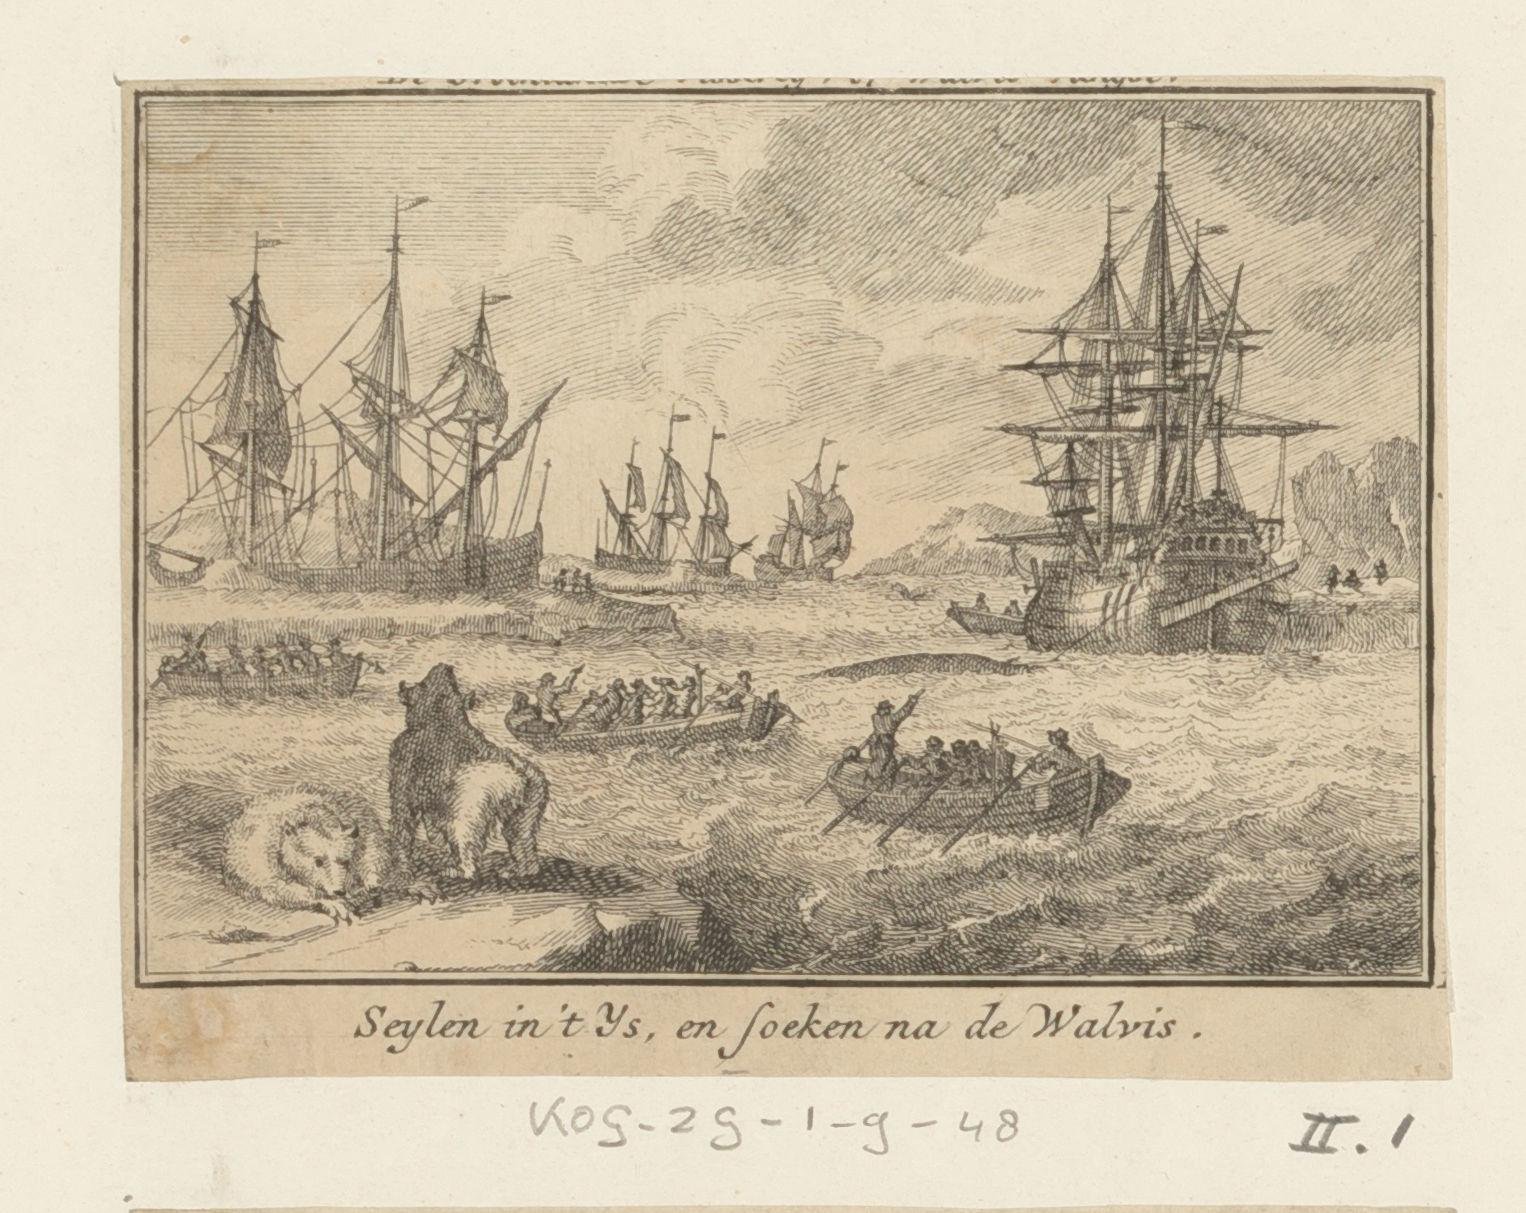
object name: print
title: Walvisjacht in de ijszee, op de voorgrond enkele ijsberen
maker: Anonymous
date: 1720-1770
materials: paper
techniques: engraving, etching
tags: beasts of prey, predatory animals: polar bear, ships (in general), whale fishery, whaling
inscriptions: stamp, collector's mark: Lugt 1641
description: Prenten zijn een verkleinde versie van de serie Groote Visserij, Visschers Atlas tot Amsterdam. Prenten door Adolf van der Laan, naar tekeningen van Sieuwert van der Meulen en uitgegeven door Pieter Schenk II. De serie bestaat uit zeventien platen over de haringvisserij en zestien platen over de walvisvangst. De serie is waarschijnlijk rond 1720 uitgegeven. De kleine prenten werden met vier voorstellingen op een plaat gedrukt. Elke afbeelding werd genummerd.